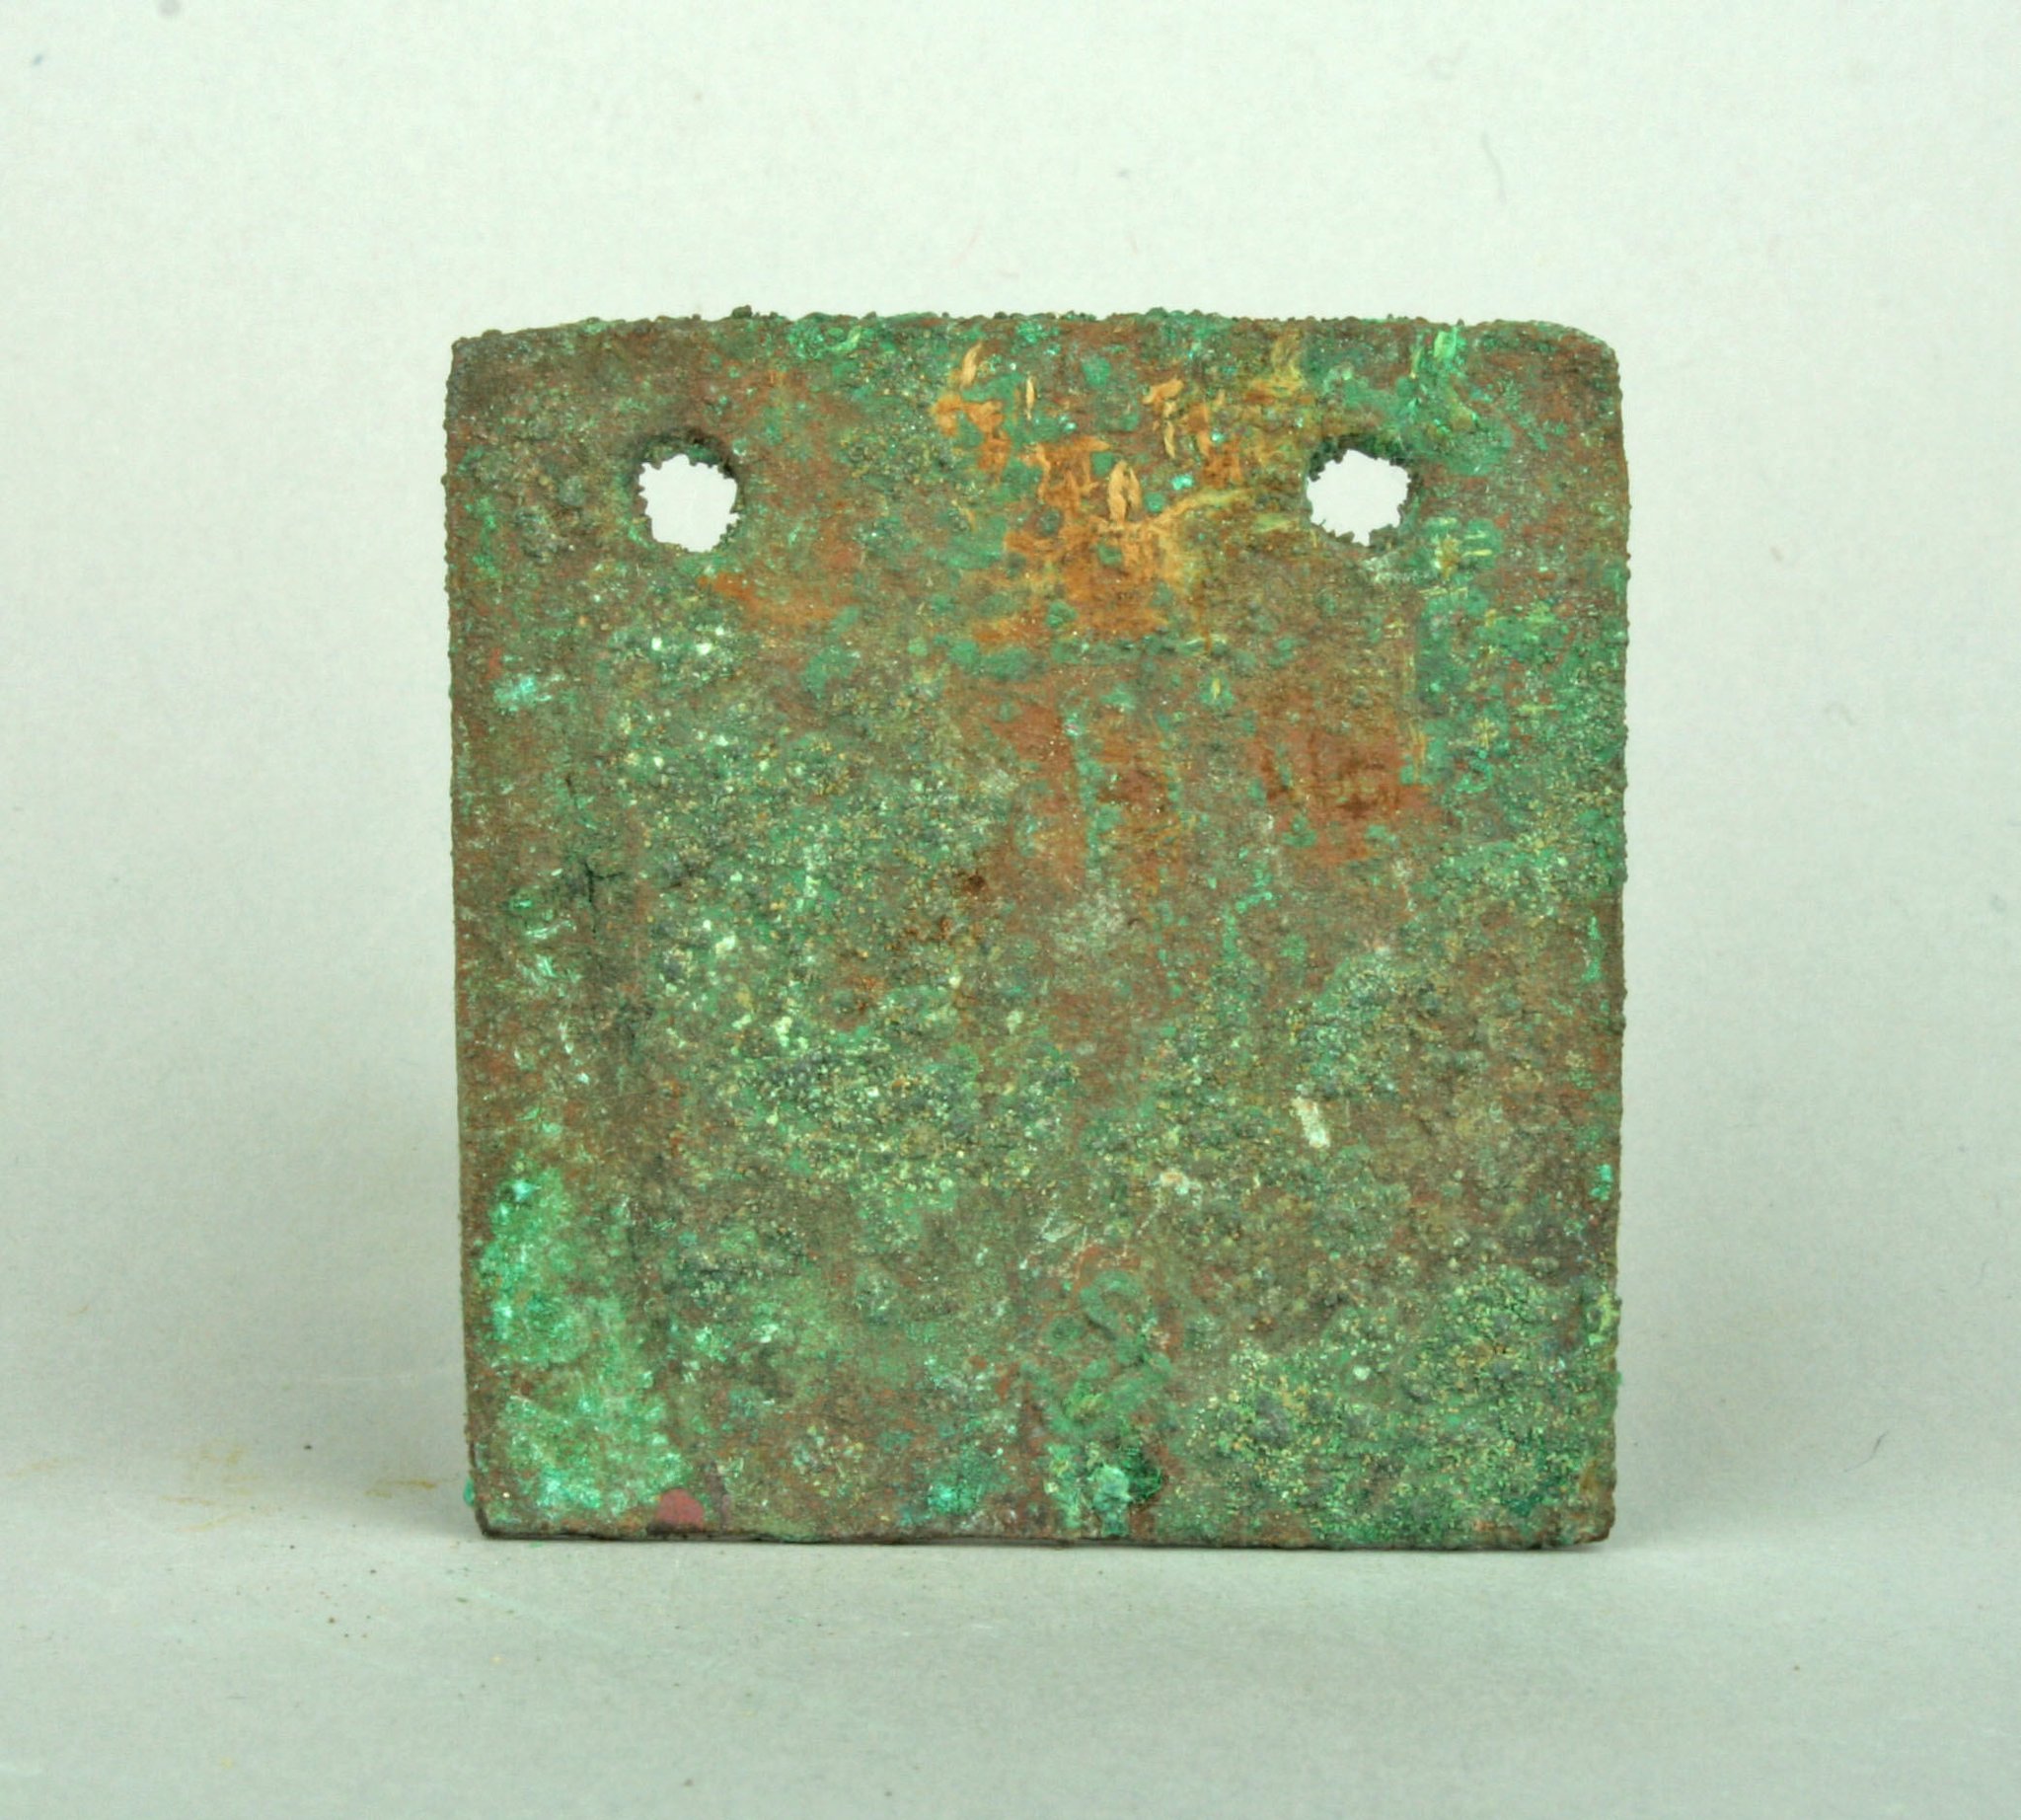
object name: plaque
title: Square Plaque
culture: vicús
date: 300 BCE-200 CE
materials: copper, gilt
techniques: hammering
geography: peru